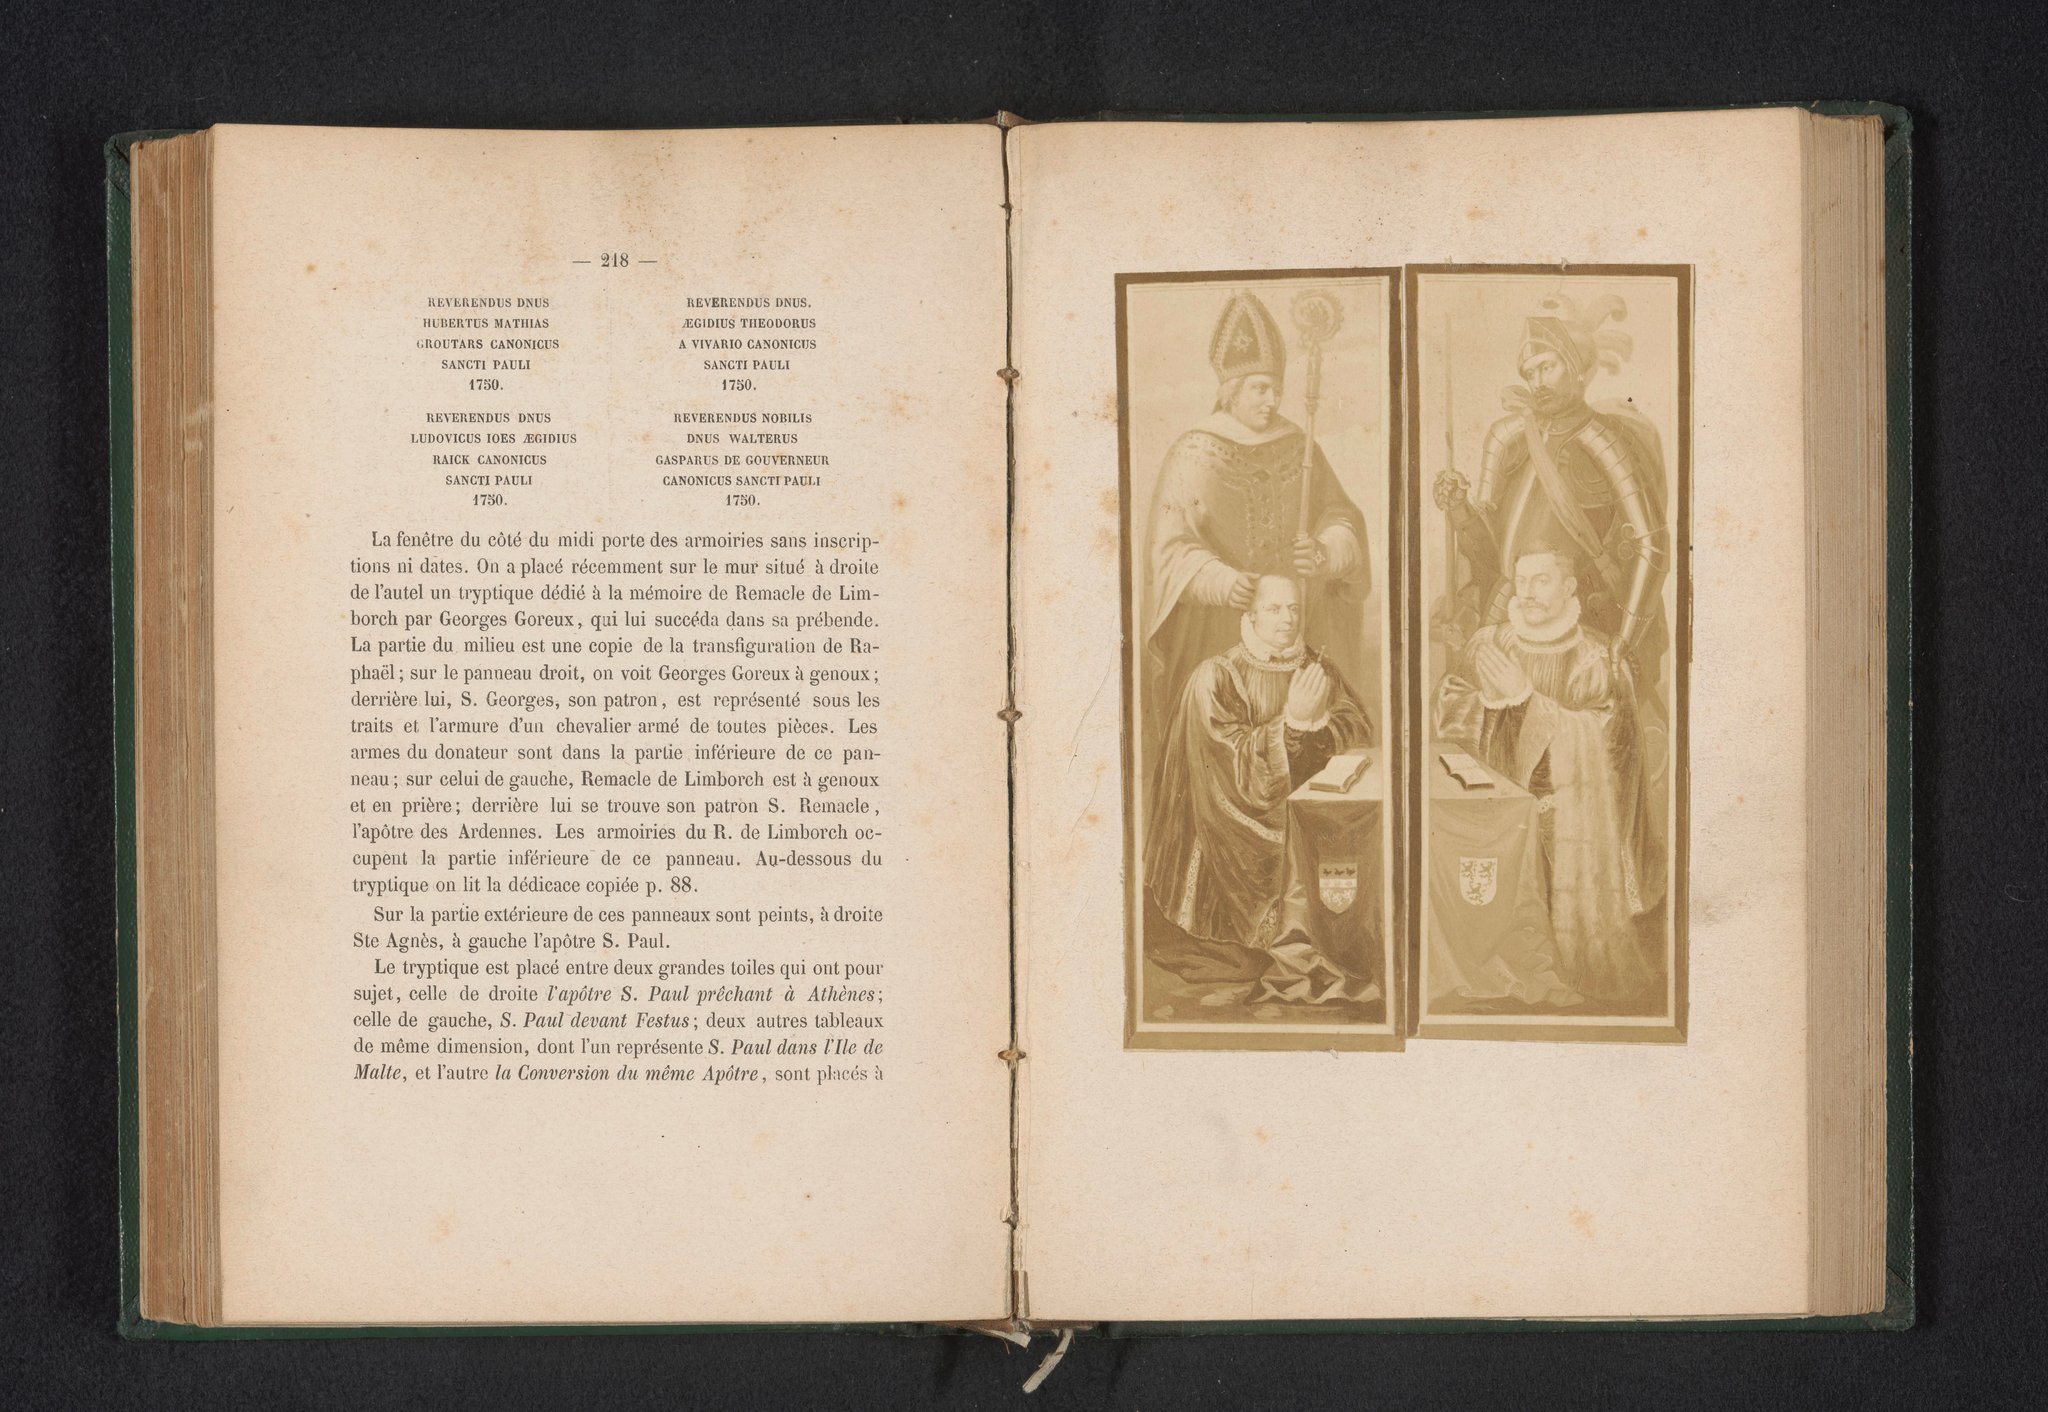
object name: page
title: Fotoreproductie van een ontwerp van een biddende man, met achter hem een soldaat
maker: Anonymous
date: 1862-1867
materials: photographic support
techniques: albumen print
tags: private soldier, one person praying